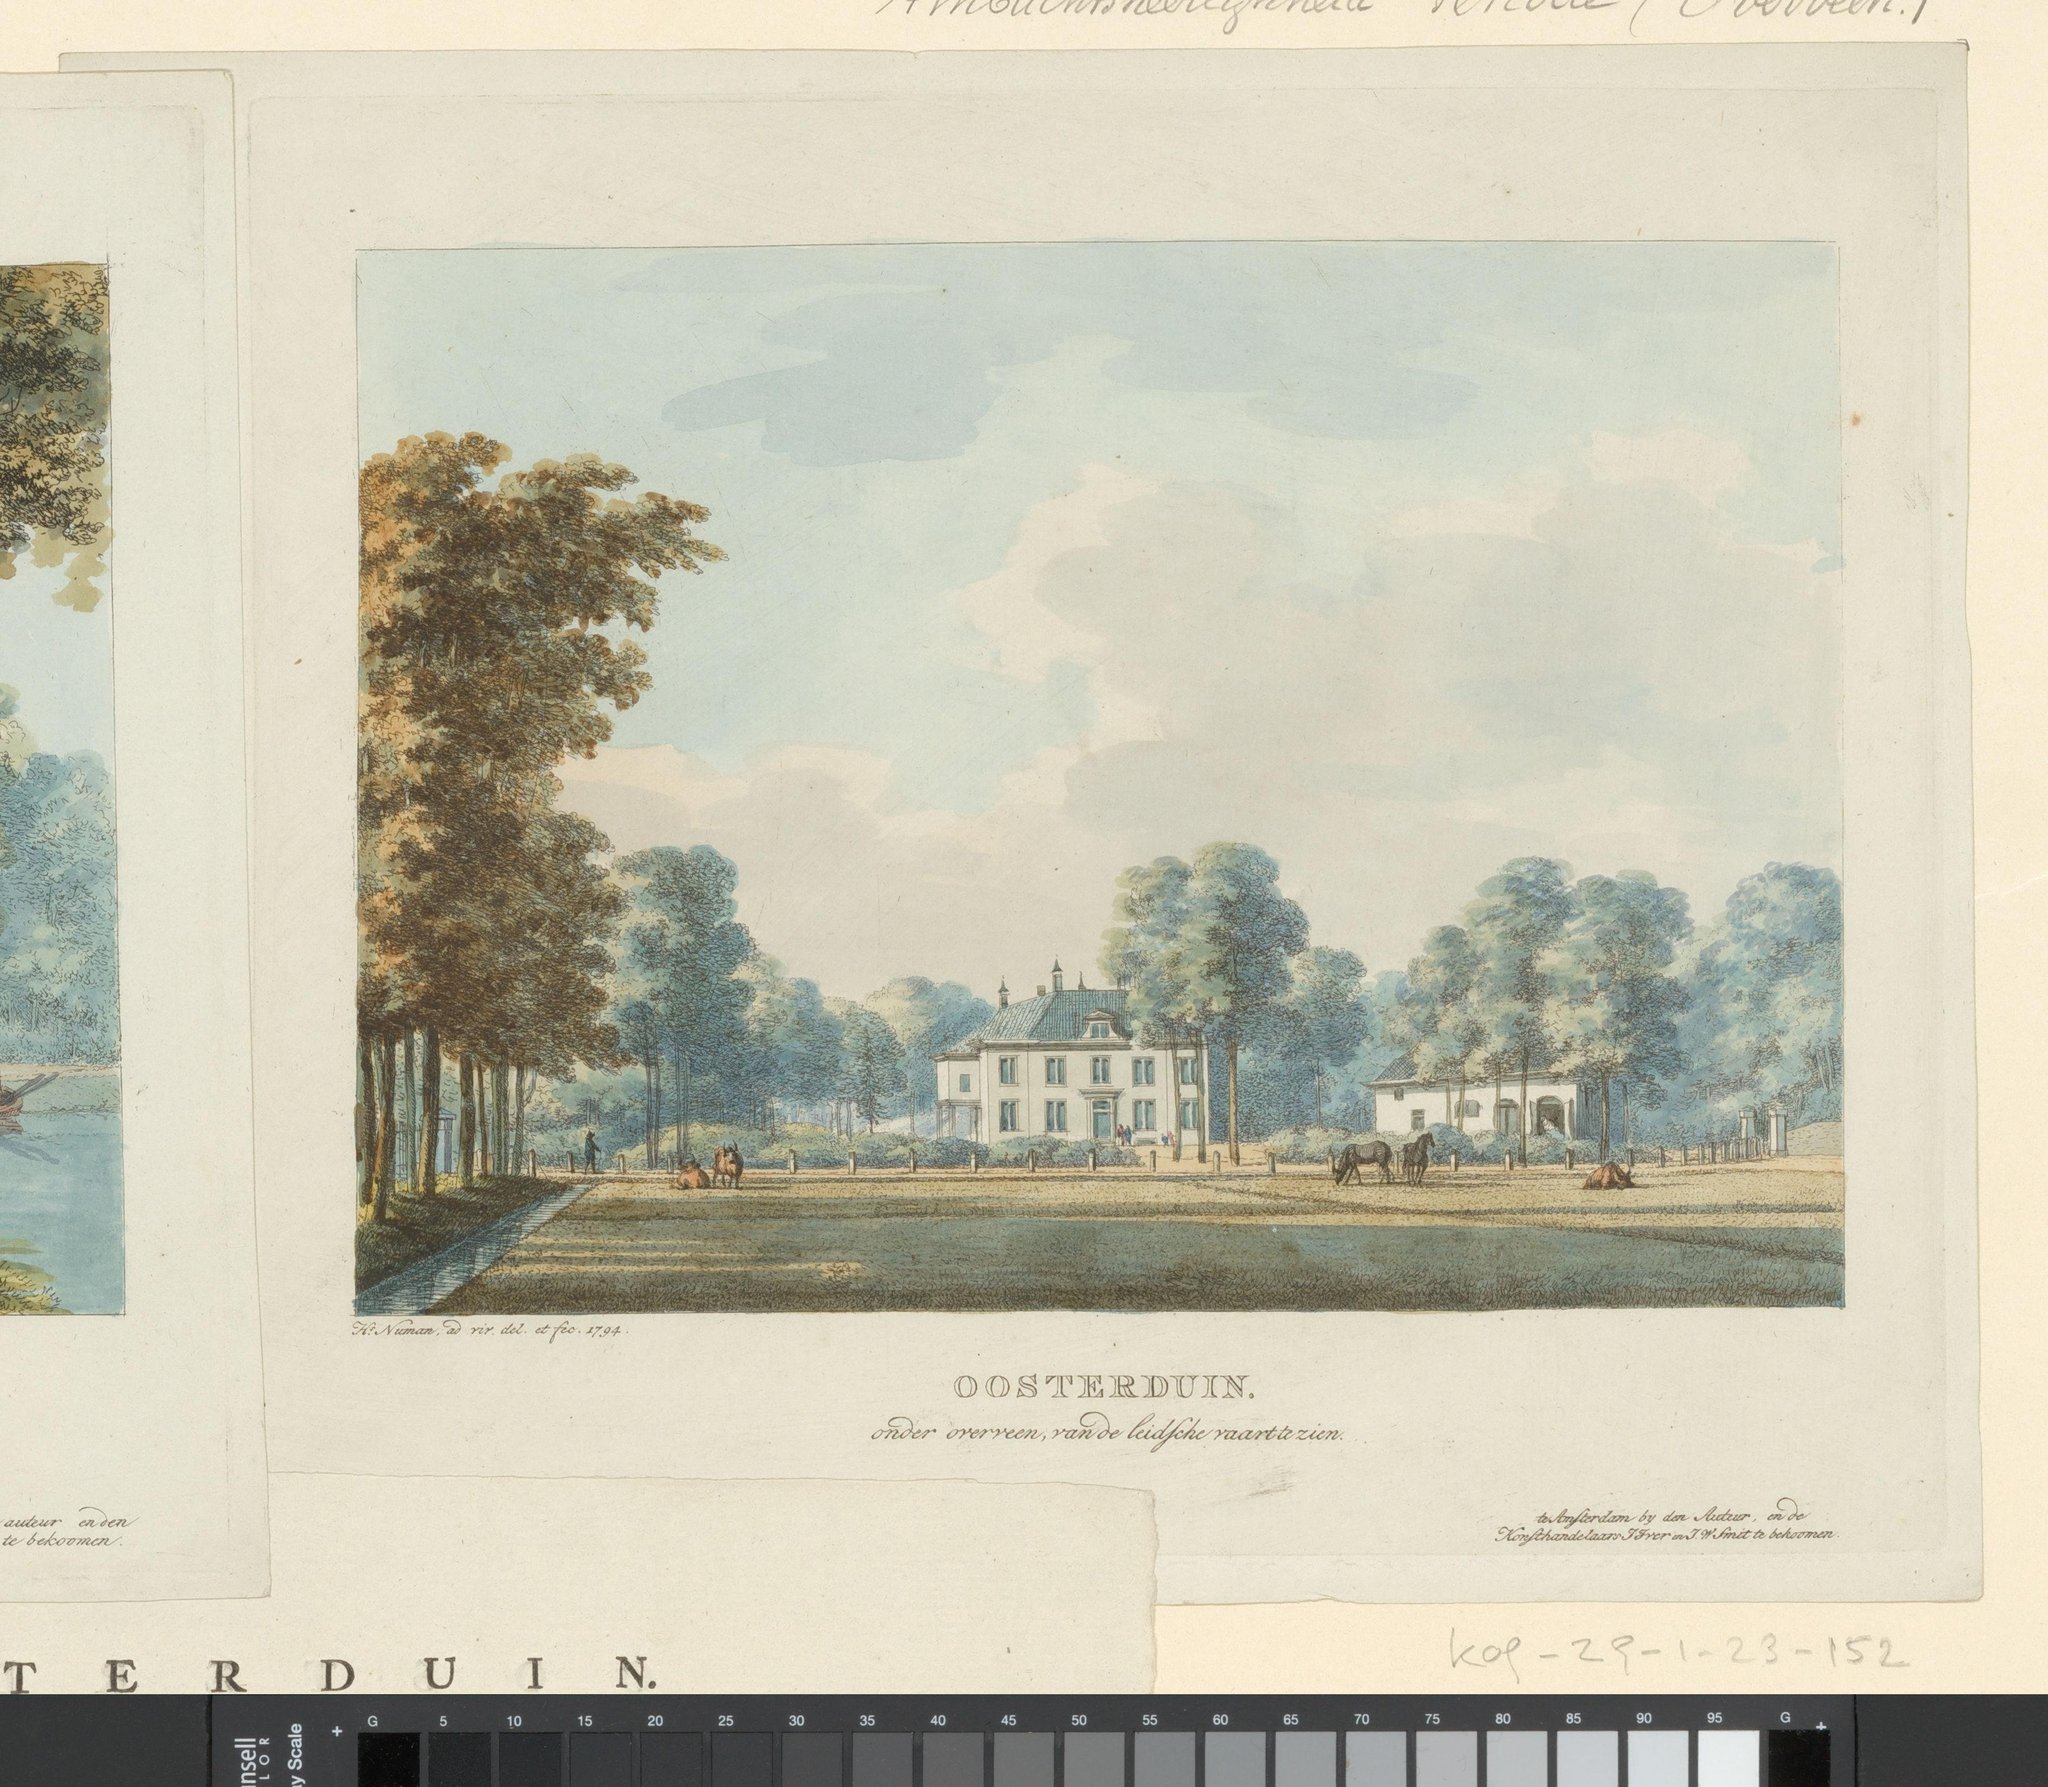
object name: print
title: Oosterduin. onder Overveen, van de Leidsche Vaart te zien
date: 1794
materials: paper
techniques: engraving, etching, hand coloring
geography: amsterdam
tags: country-house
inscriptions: stamp, stamp, collector's mark: Lugt 1641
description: Prent gebruikt in: Numan, Hermanus. Vierentwintig printtekeningen met couleuren, verbeeldende Hollandsche buitenplaatzen. Amsterdam: Jan IJver, Jan Willem Smit en Hermanus Numan, 1797.